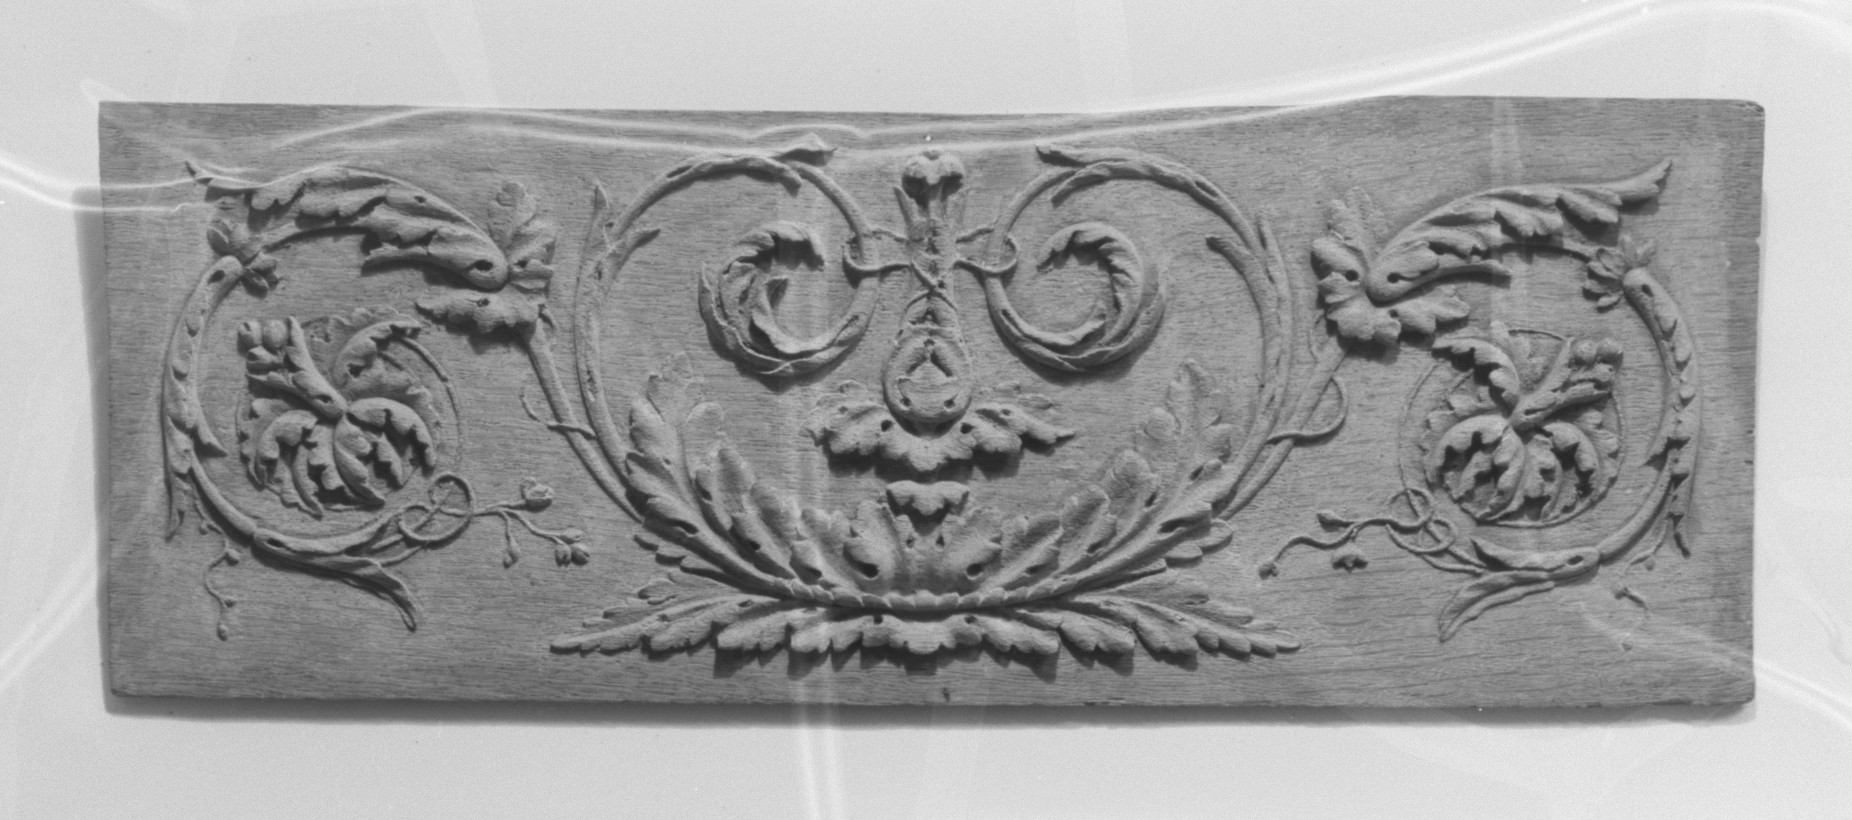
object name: panel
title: Pair of panels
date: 1701-1800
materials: wood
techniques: carving, painting